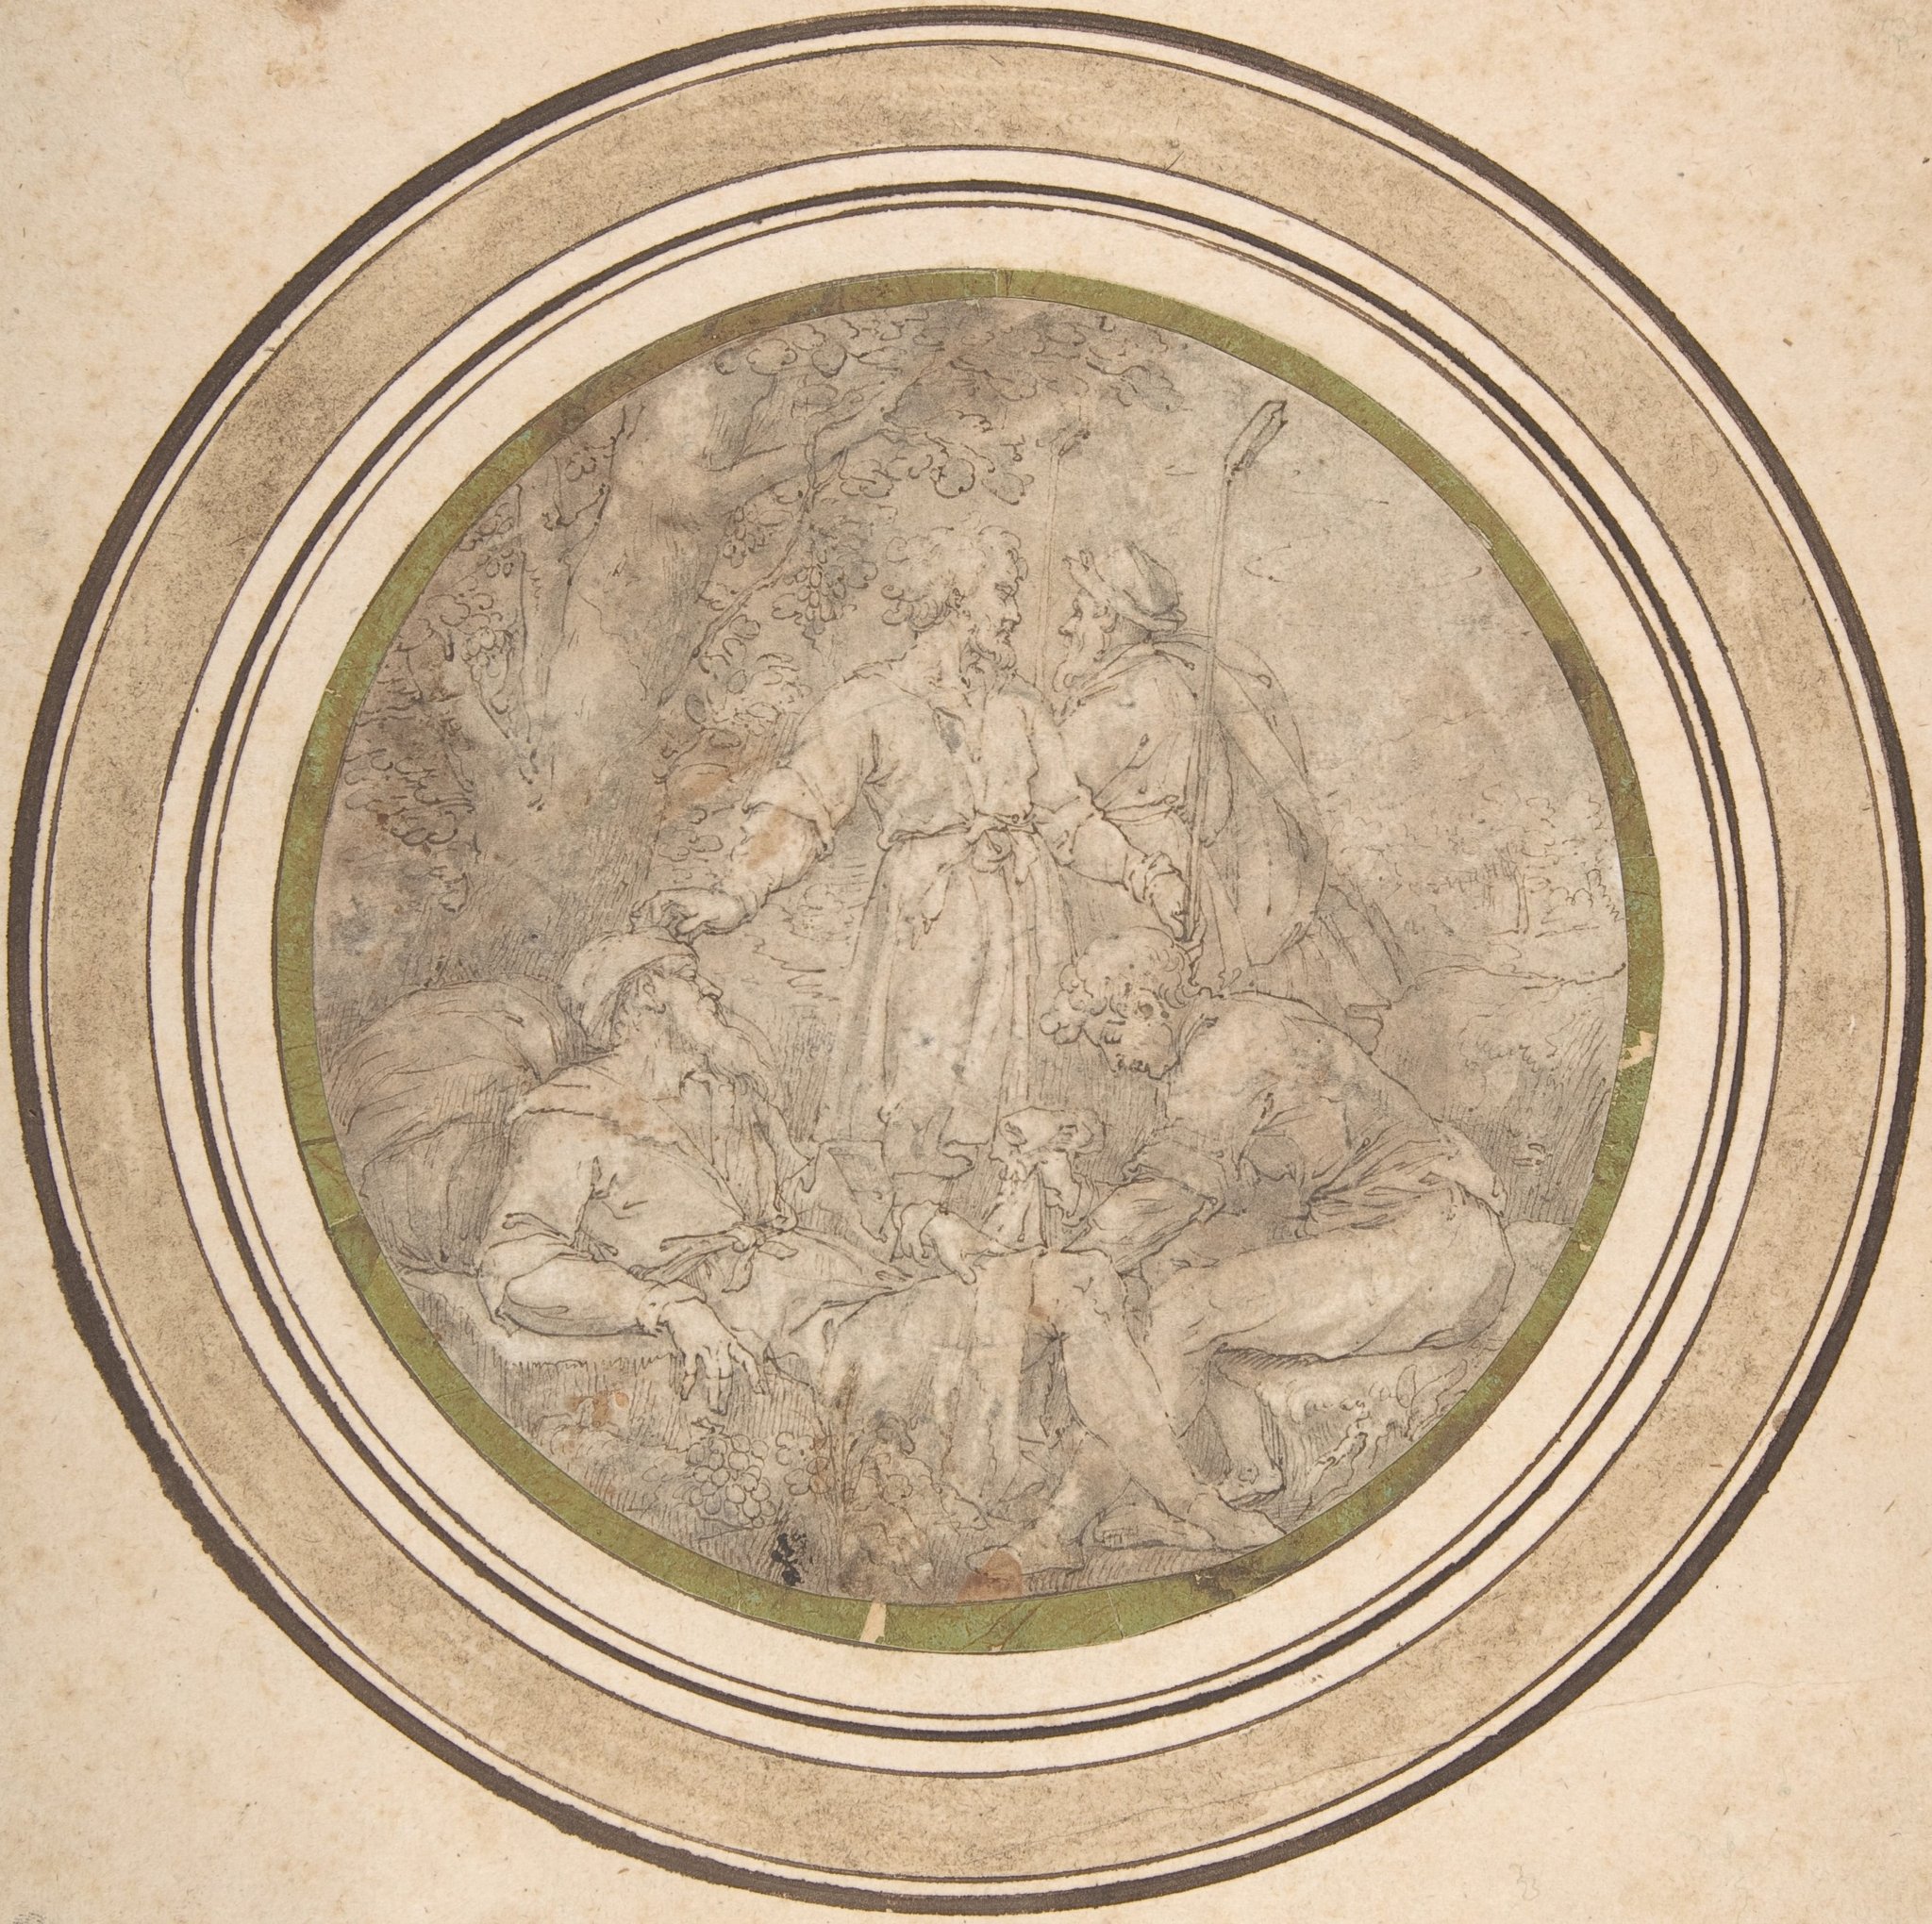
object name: drawing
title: The Drunkenness of Noah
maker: friedrich sustris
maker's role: artist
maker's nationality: netherlandish, born italy (?)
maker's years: 1535-1599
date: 1550-1600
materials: ink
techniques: pen, wash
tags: drunkenness,men